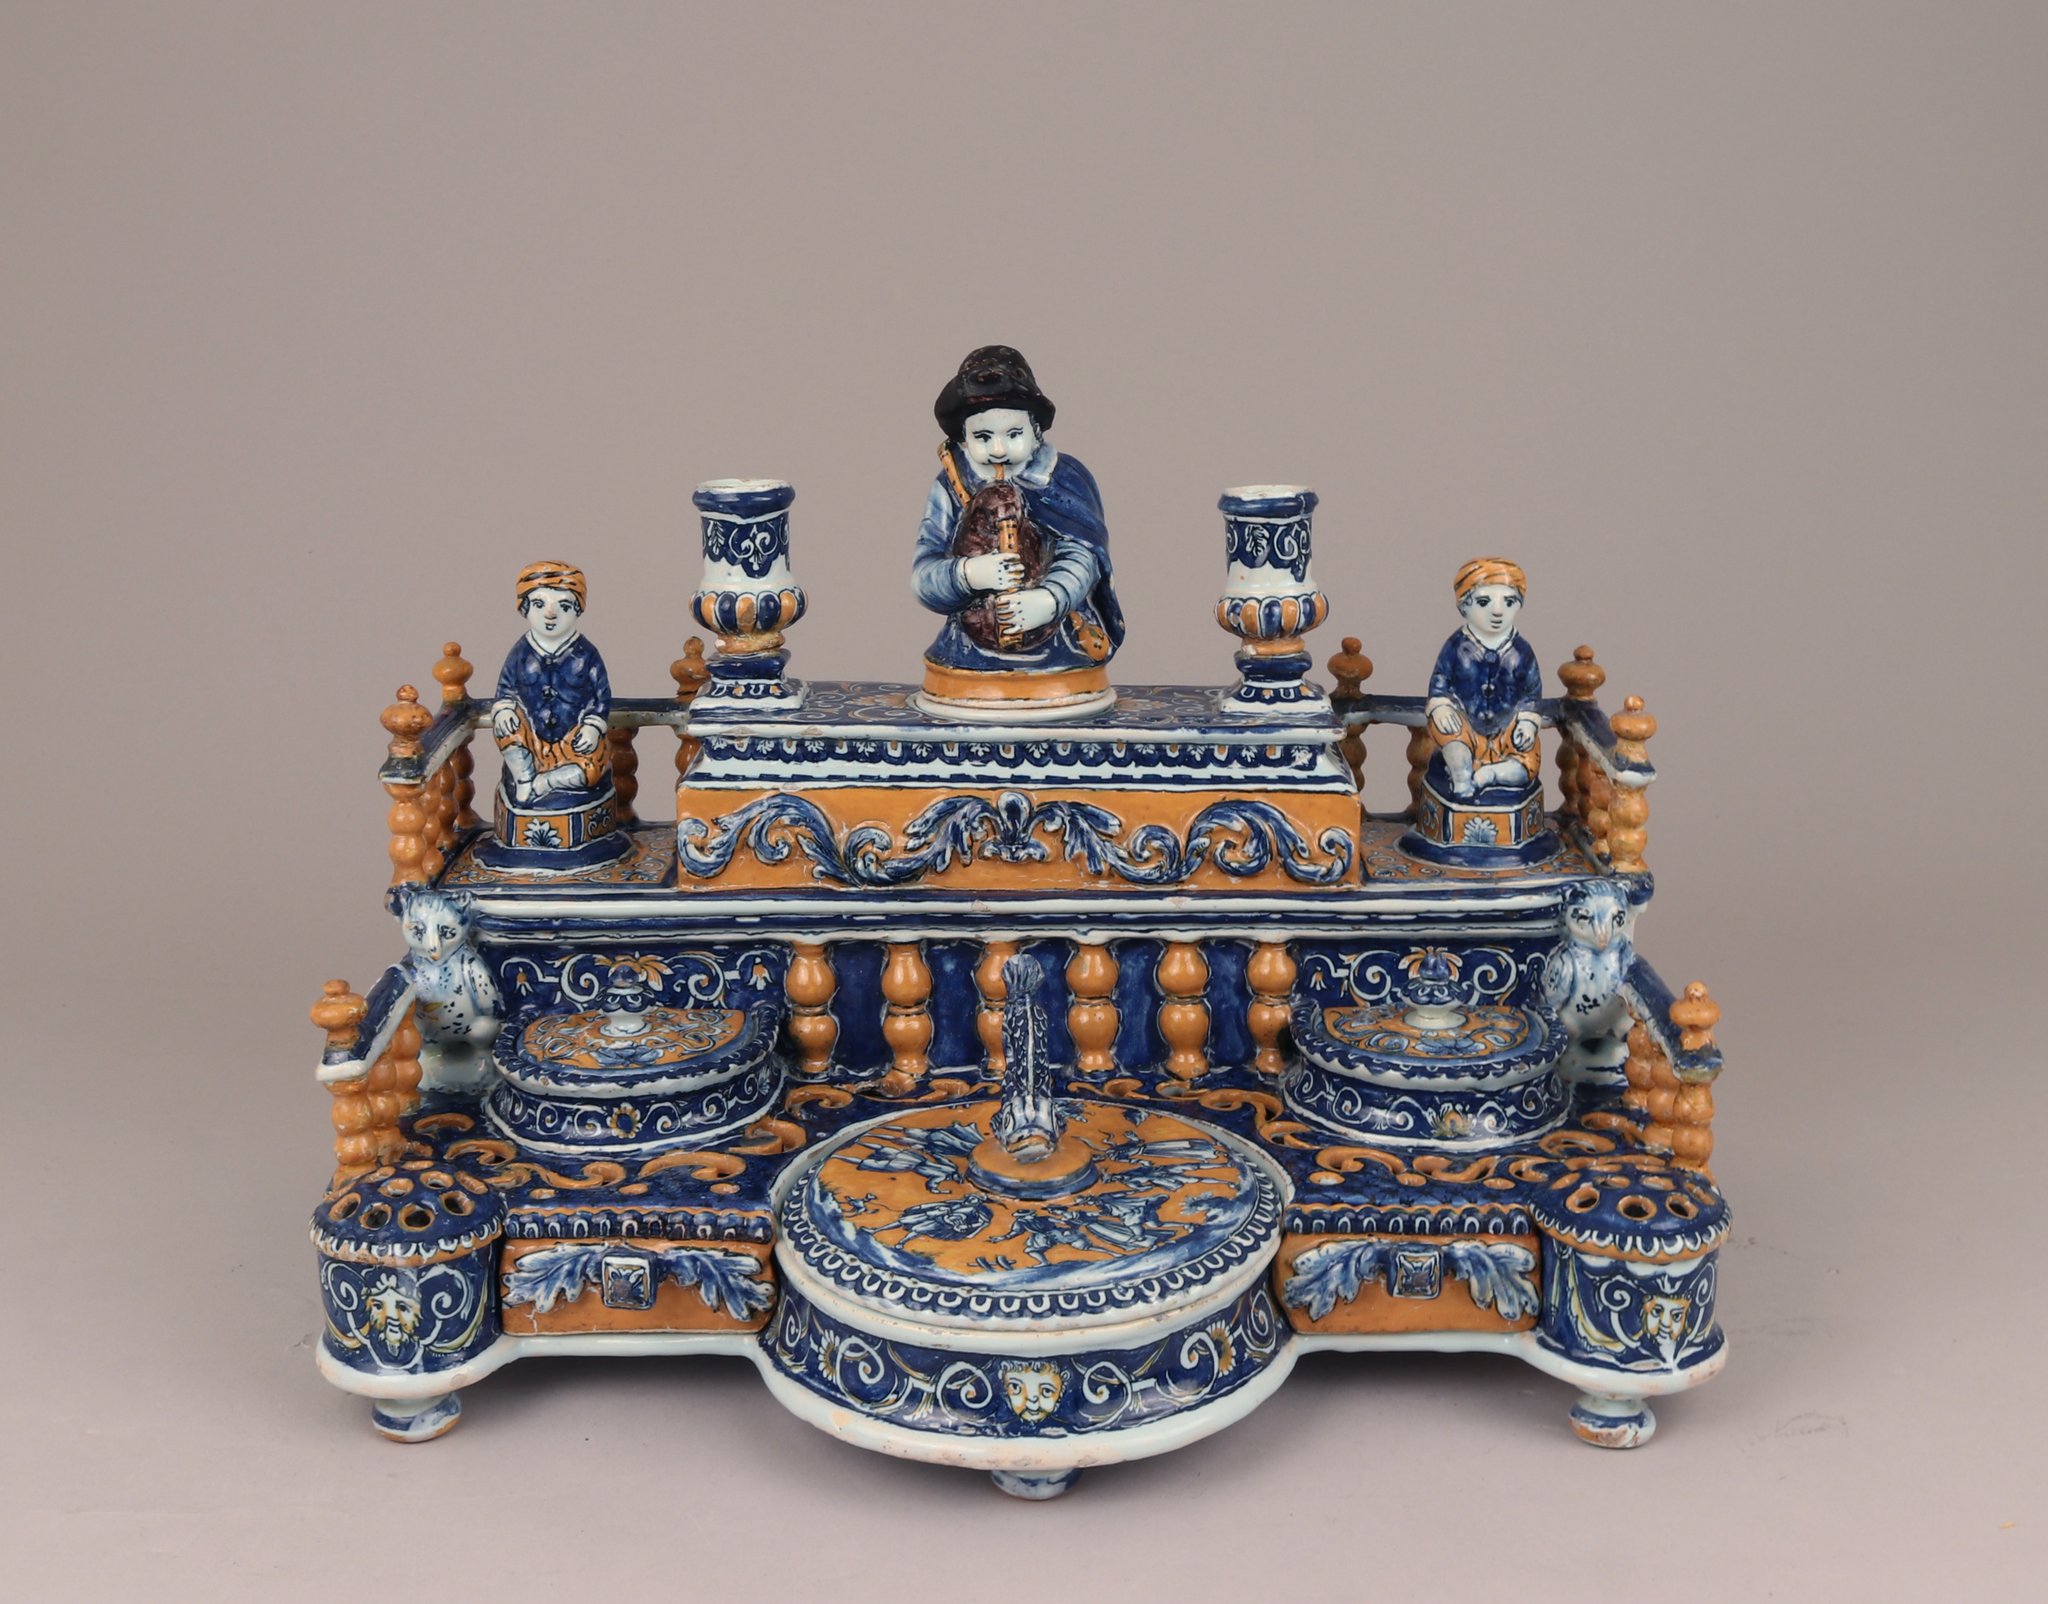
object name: inkstand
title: Inkstand (Écritoire)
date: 1701-1800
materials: faience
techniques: glazing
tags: boys,men,bagpipes,owls,dolphins